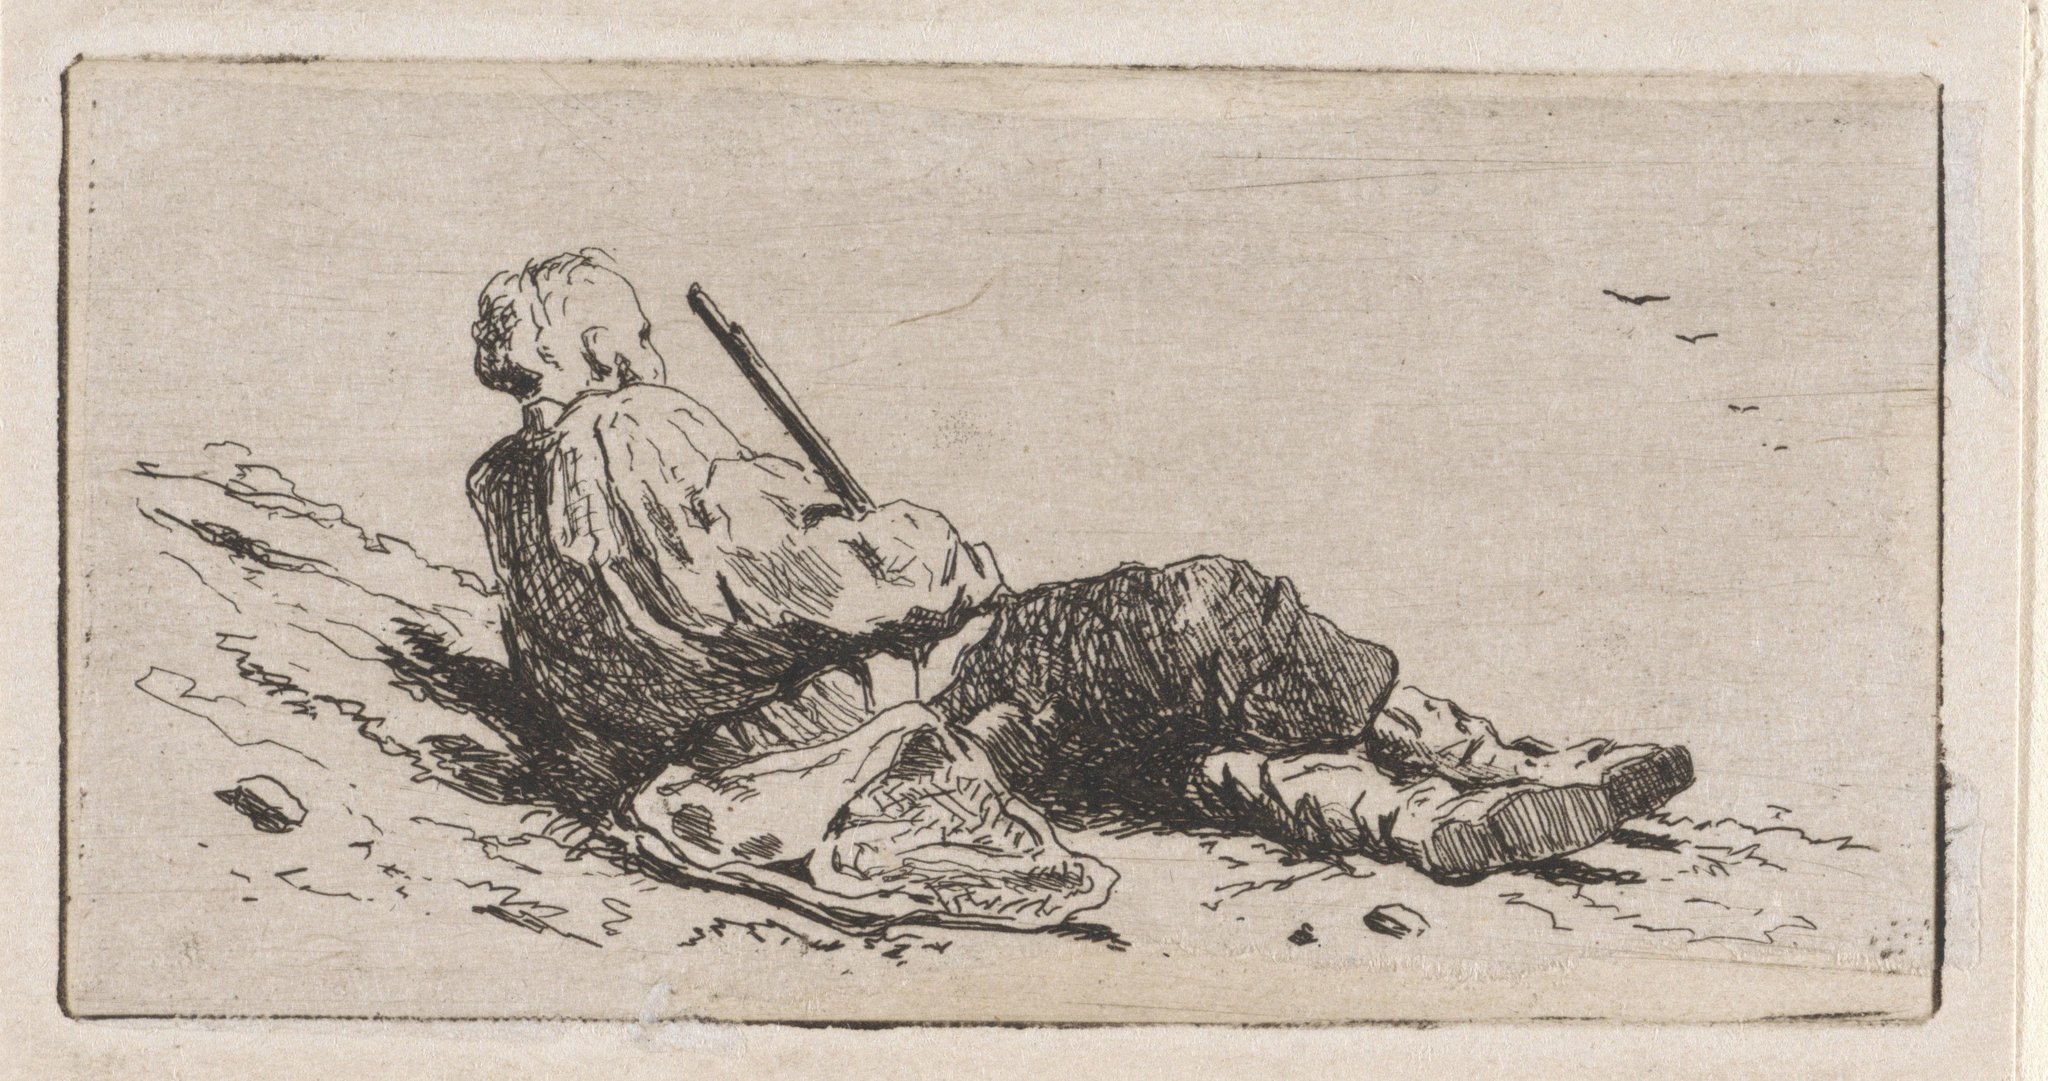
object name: print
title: Liggende jager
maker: jan weissenbruch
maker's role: painter, print maker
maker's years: 1822-1880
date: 1837-1880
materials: paper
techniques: etching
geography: the hague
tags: landscapes, birds, bag, hunter, firearms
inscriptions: collector's mark: Lugt 2228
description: Op de grond ligt een jager naast zijn tas. In de verte vliegen enkele vogels.